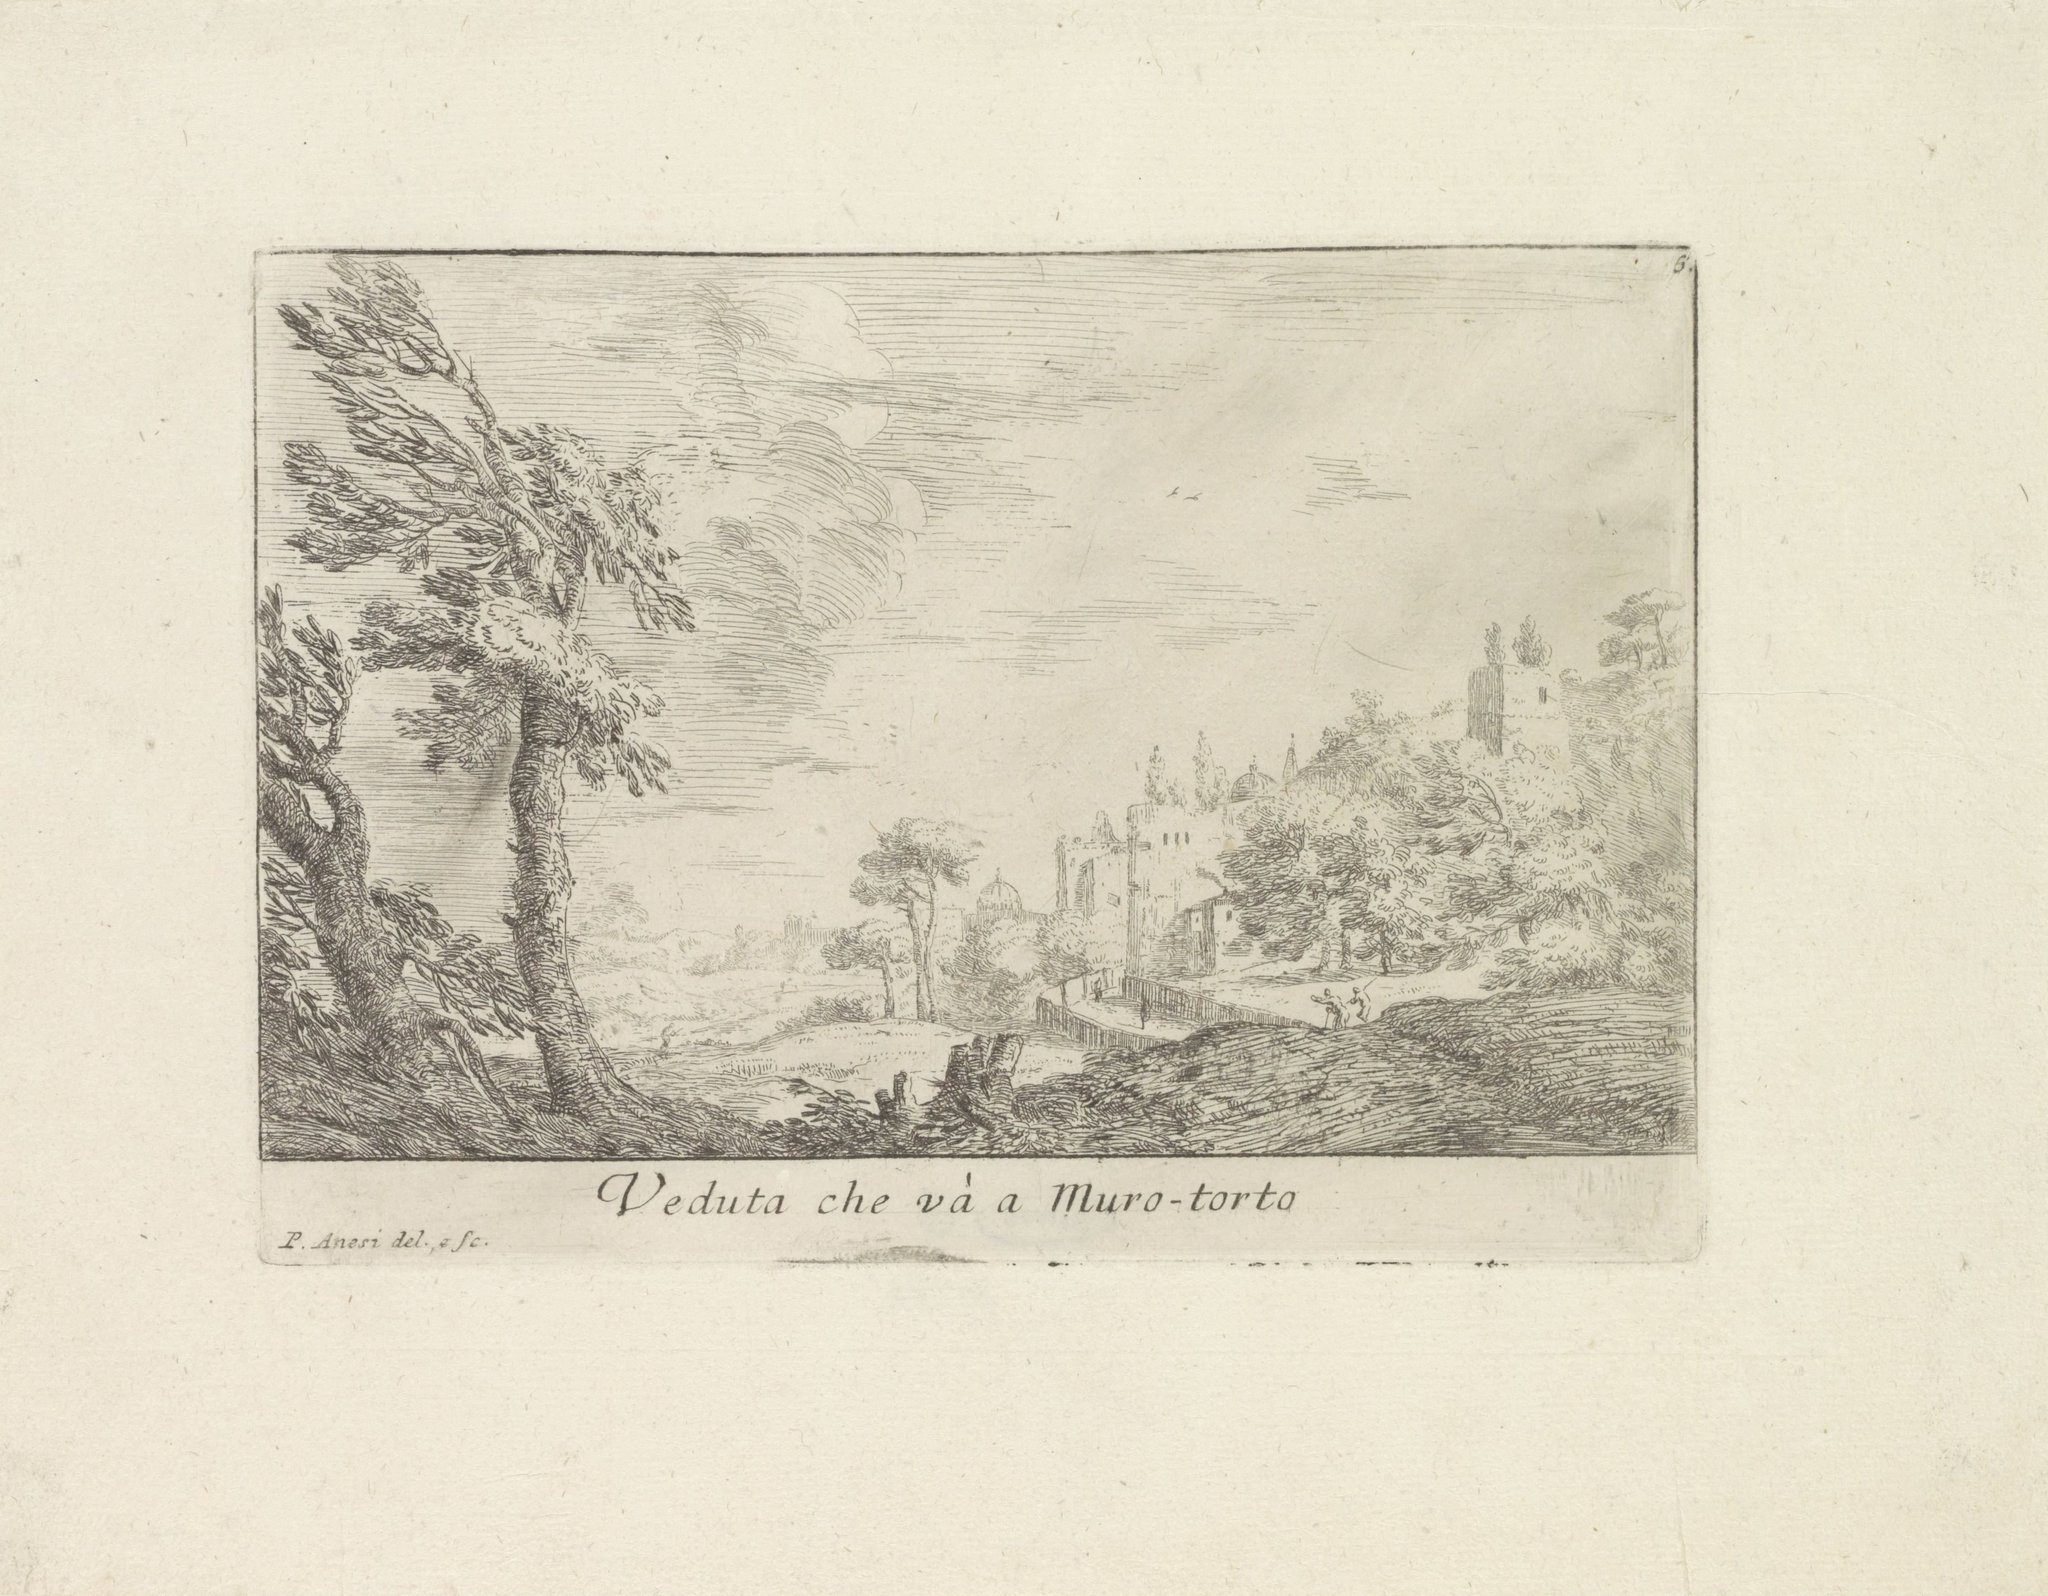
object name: print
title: Landschap met de Muro Torto in Rome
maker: paolo anesi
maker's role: print maker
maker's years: 1700-1761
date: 1725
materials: paper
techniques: etching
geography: rome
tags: city-view, and landscape with man-made constructions, city-walls, rome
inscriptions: collector's mark: Lugt 2760, collector's mark: Lugt 2228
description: Landschap met rechts de Muro Torto in Rome. Onder de voorstelling de titel. Genummerd rechtsboven: 6.